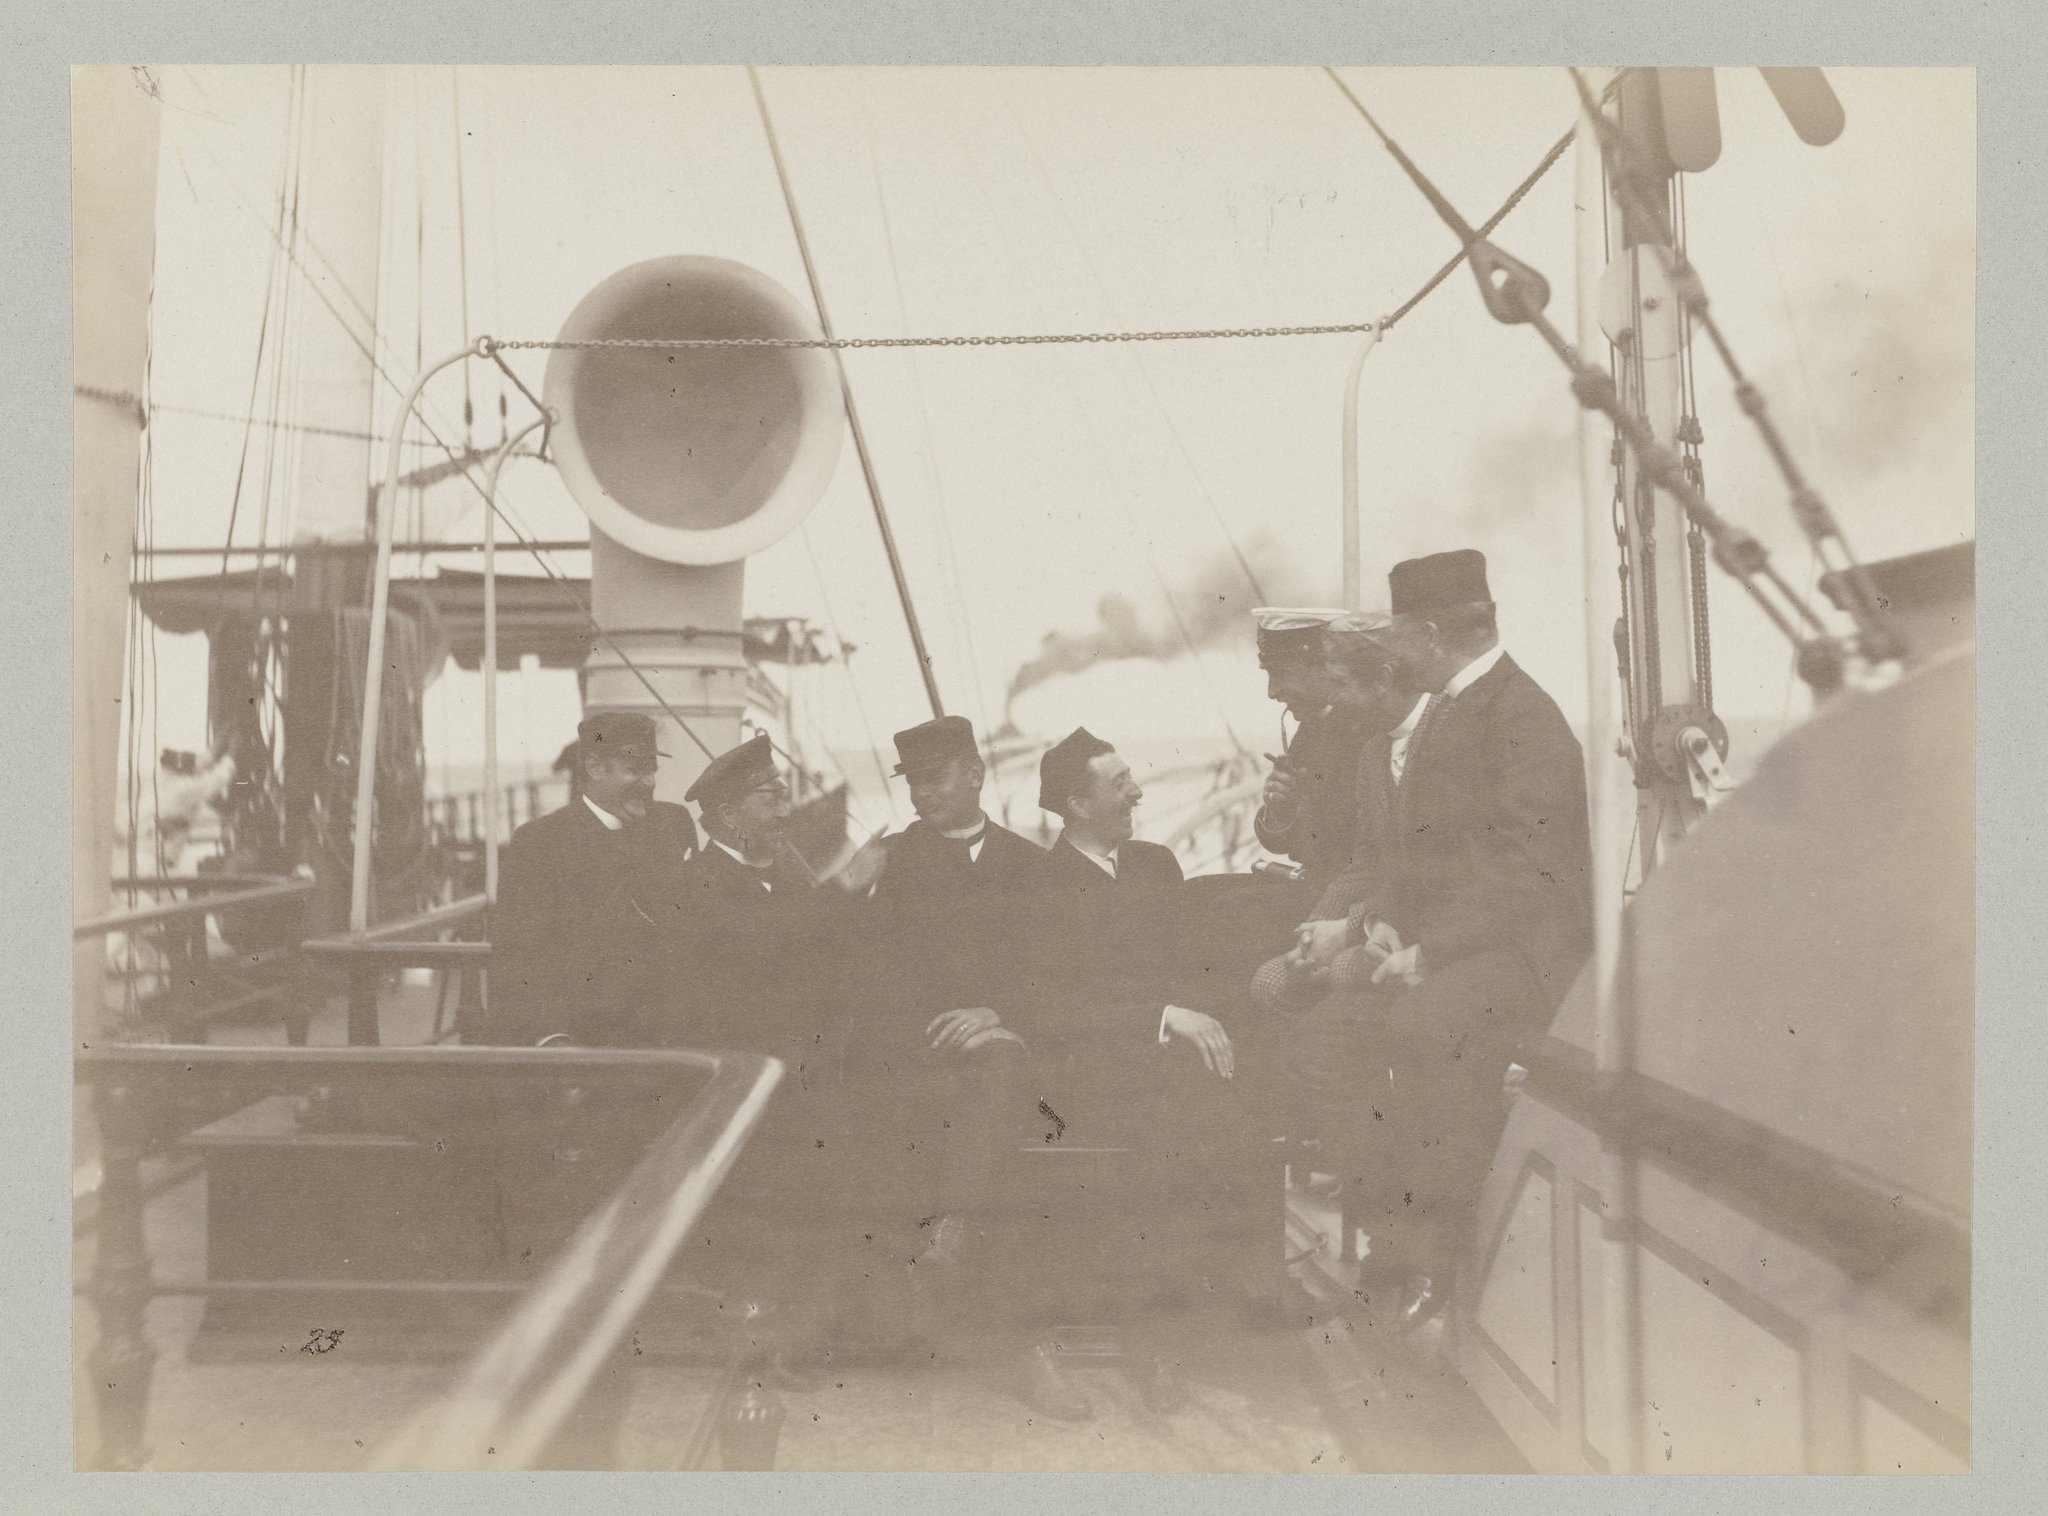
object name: photograph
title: Eine heitere Geschichte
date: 1807-1889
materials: cardboard, paper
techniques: albumen print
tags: wilhelm ii (keizer van duitsland), norway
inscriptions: number: ‘37’, number: ‘29’